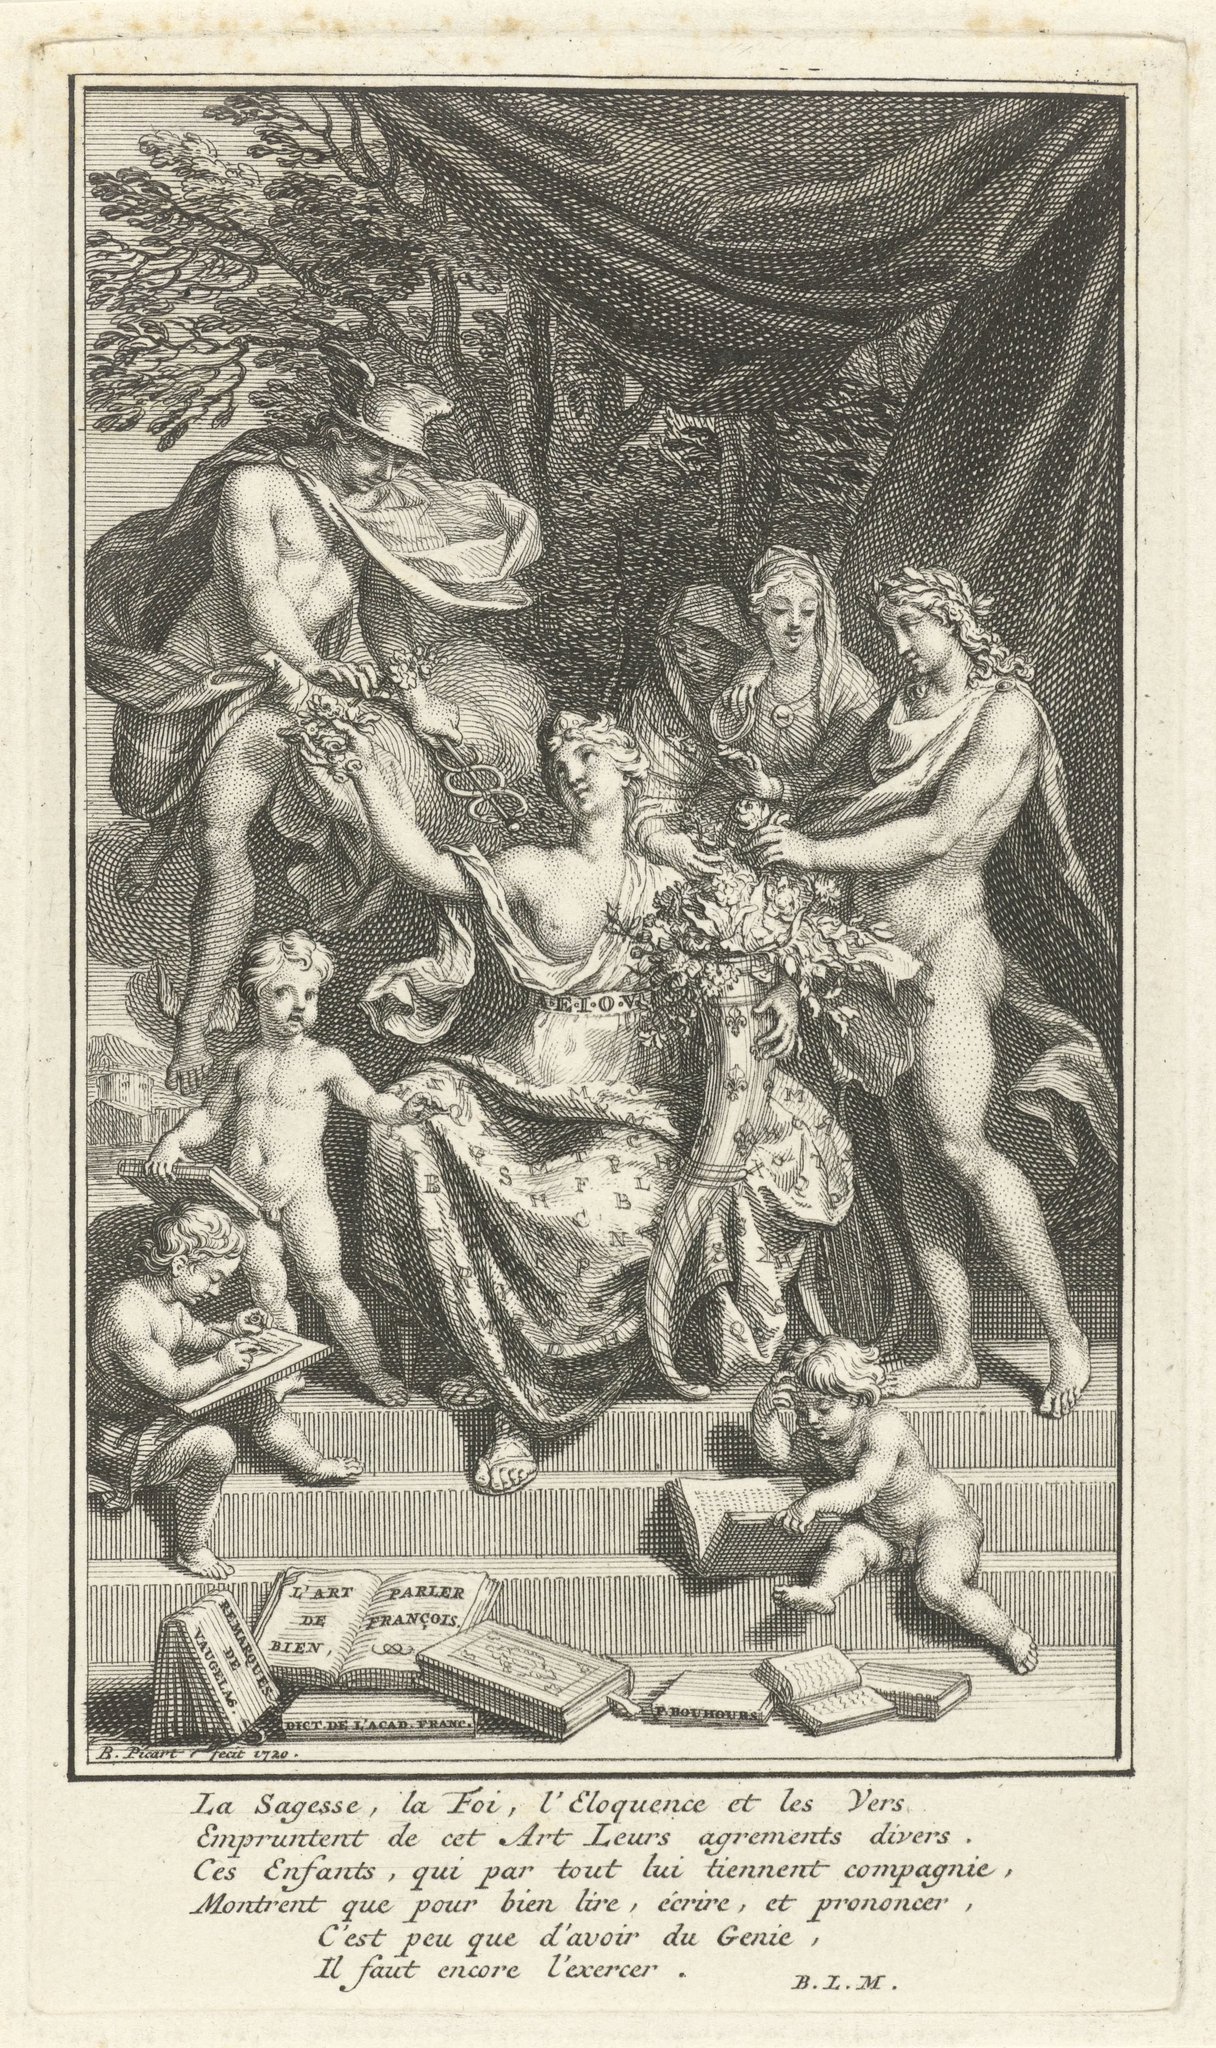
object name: print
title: Allegorie op welsprekendheid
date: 1720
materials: paper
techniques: engraving, etching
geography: amsterdam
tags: faith, 'fides'; 'fede', 'fede catholica', 'fede christiana', 'fede christiana catholica' (ripa) ~ one of the three theological virtues, hermes logios, mercury as god of eloquence, eloquence; 'eloquenza', 'fermezza & gravità dell'oratione' (ripa) (+ symbolical representation of concept), wisdom, 'sapientia' ~ one of the seven gifts of the soul, symbolic representations, allegories and emblems ~ poetry; 'poesia' (ripa)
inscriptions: collector's mark: Lugt 240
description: Allegorische voorstelling met in het midden Poëzie in een met letters geborduurde jurk, een hoorn des overvloeds in de hand, als verwijzing naar de vruchtbare ideeën die zij tot uitdrukking brengt. Ze ontvangt bloemen van Mercurius (welsprekendheid), Apollo (dichtkunst) en Geloof en Wijsheid. Op de voorgrond putti die leren spreken en lezen. In de marge een zesregelig onderschrift in het Frans.